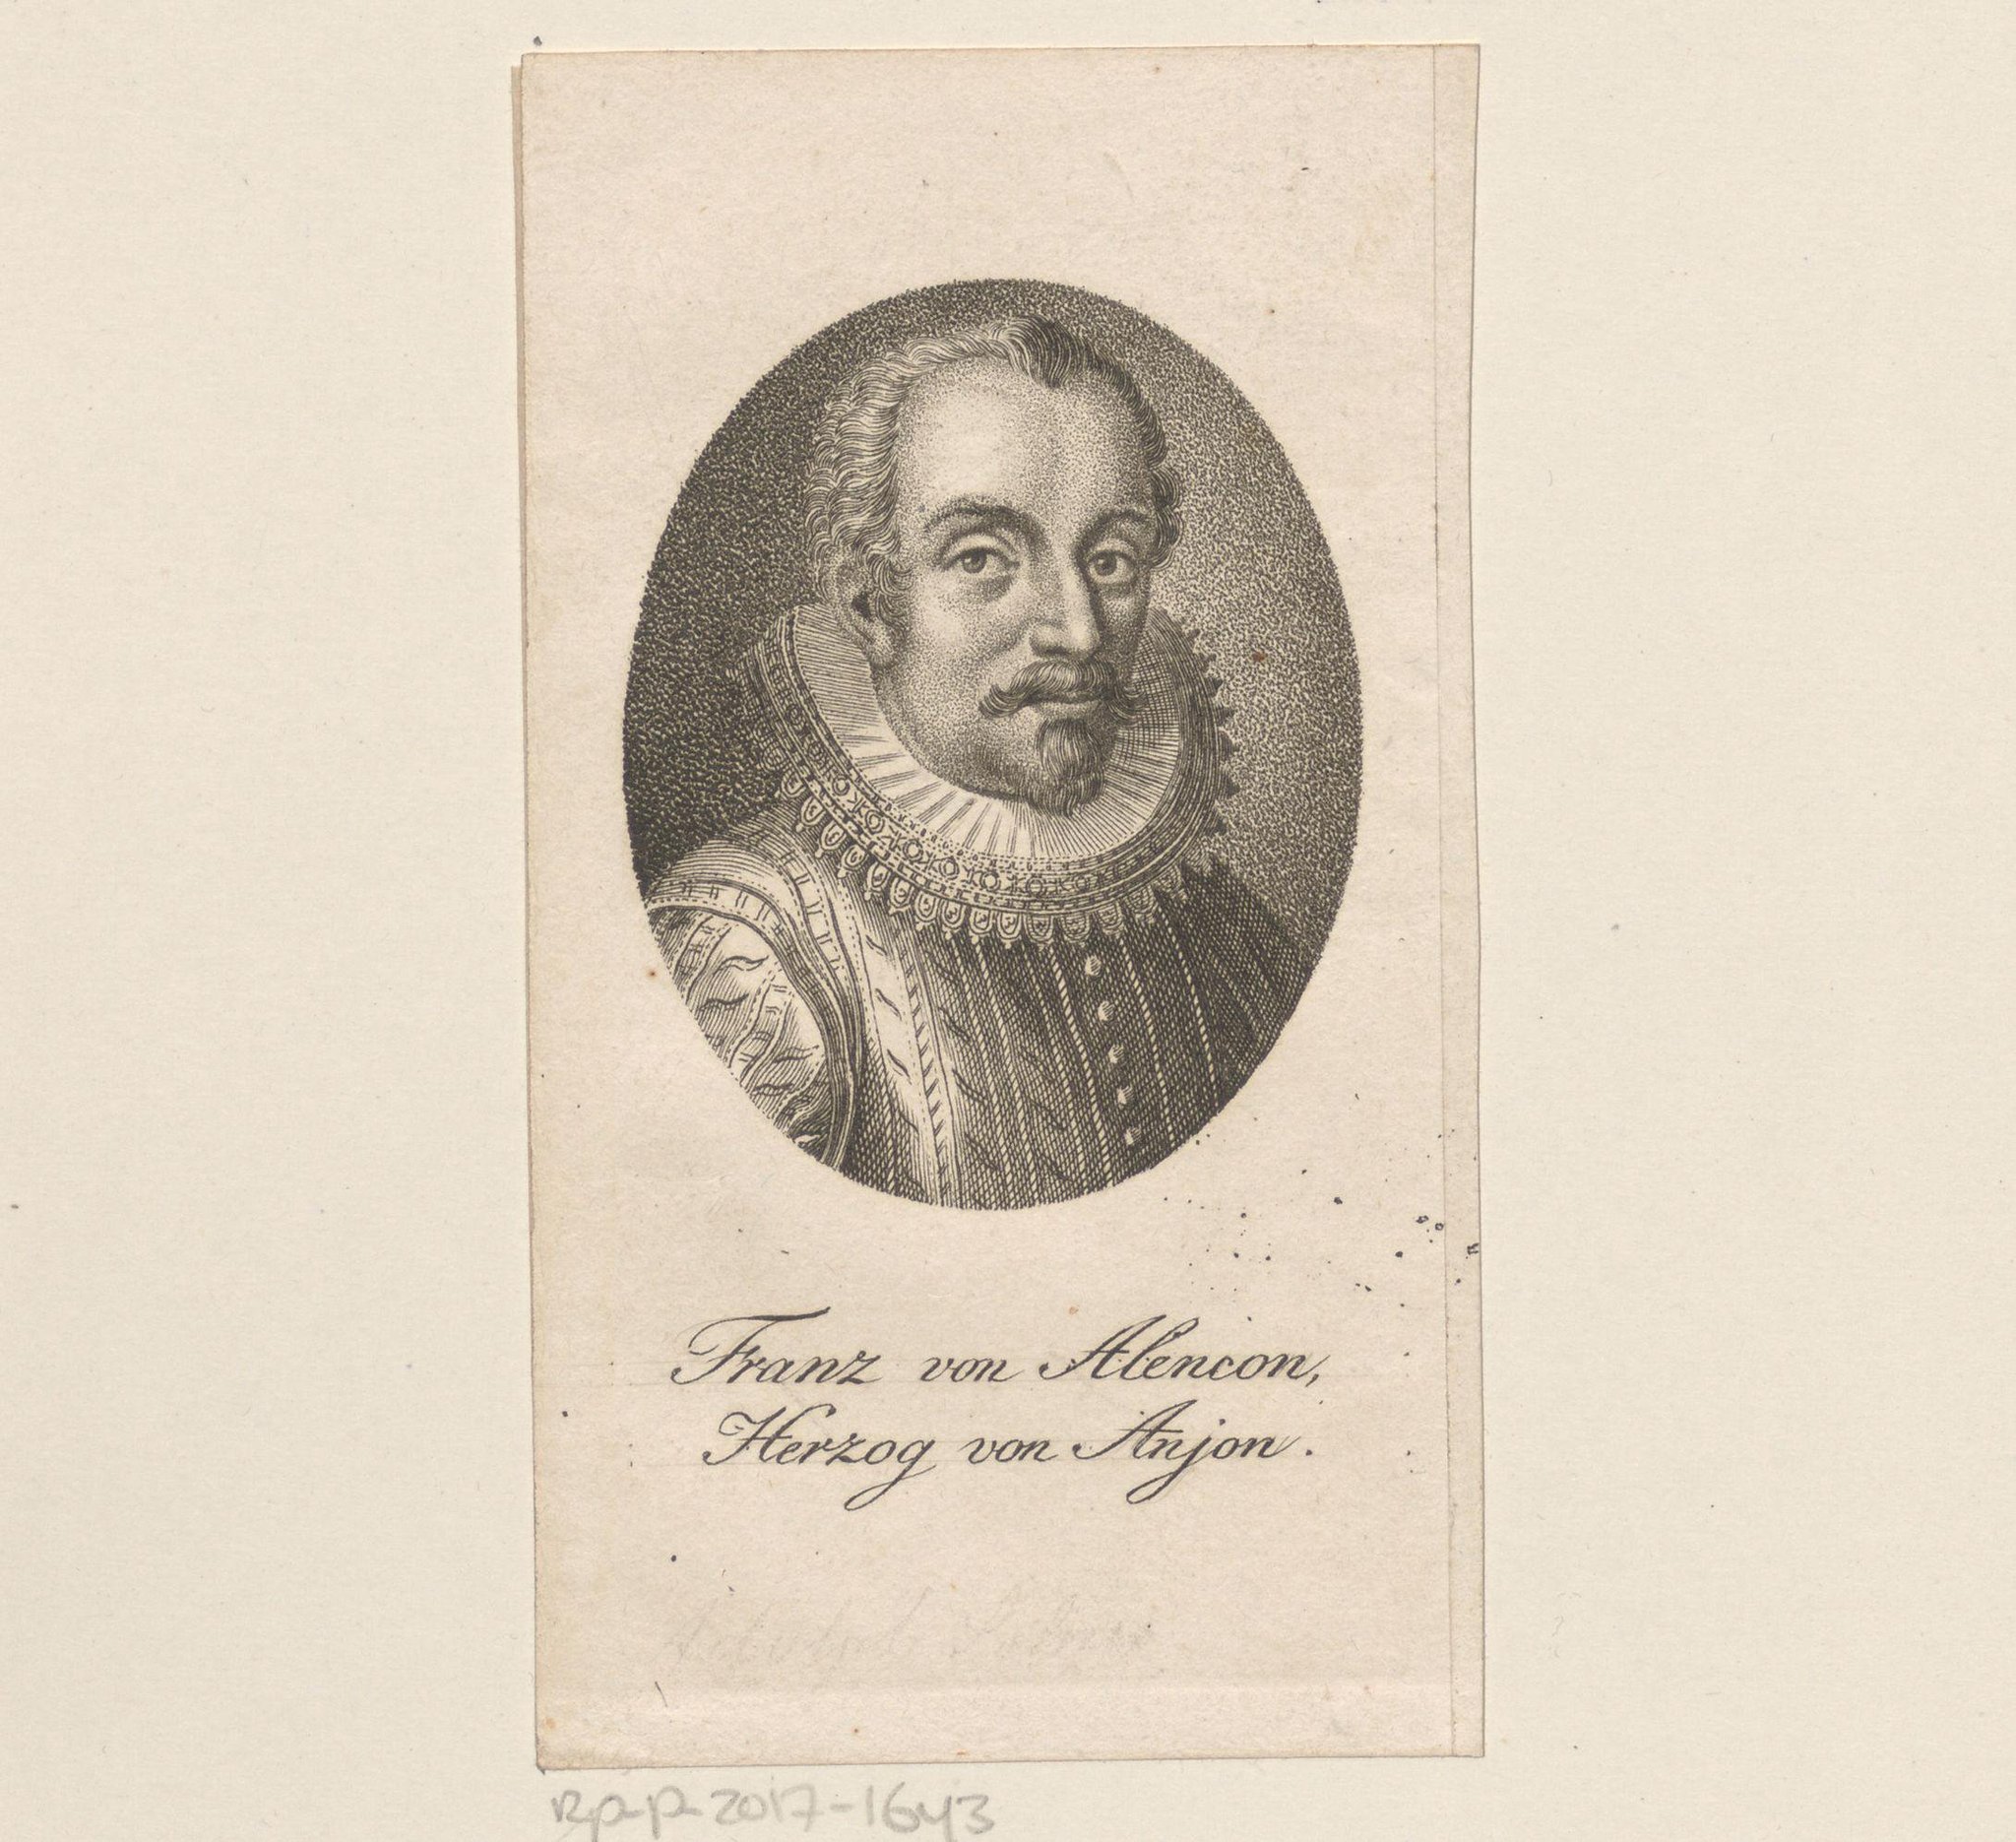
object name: print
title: Portret van François-Hercule de Valois, hertog van Anjou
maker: Anonymous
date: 1700-1799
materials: paper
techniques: engraving, etching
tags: paris, françois-hercule de valois (hertog van anjou)